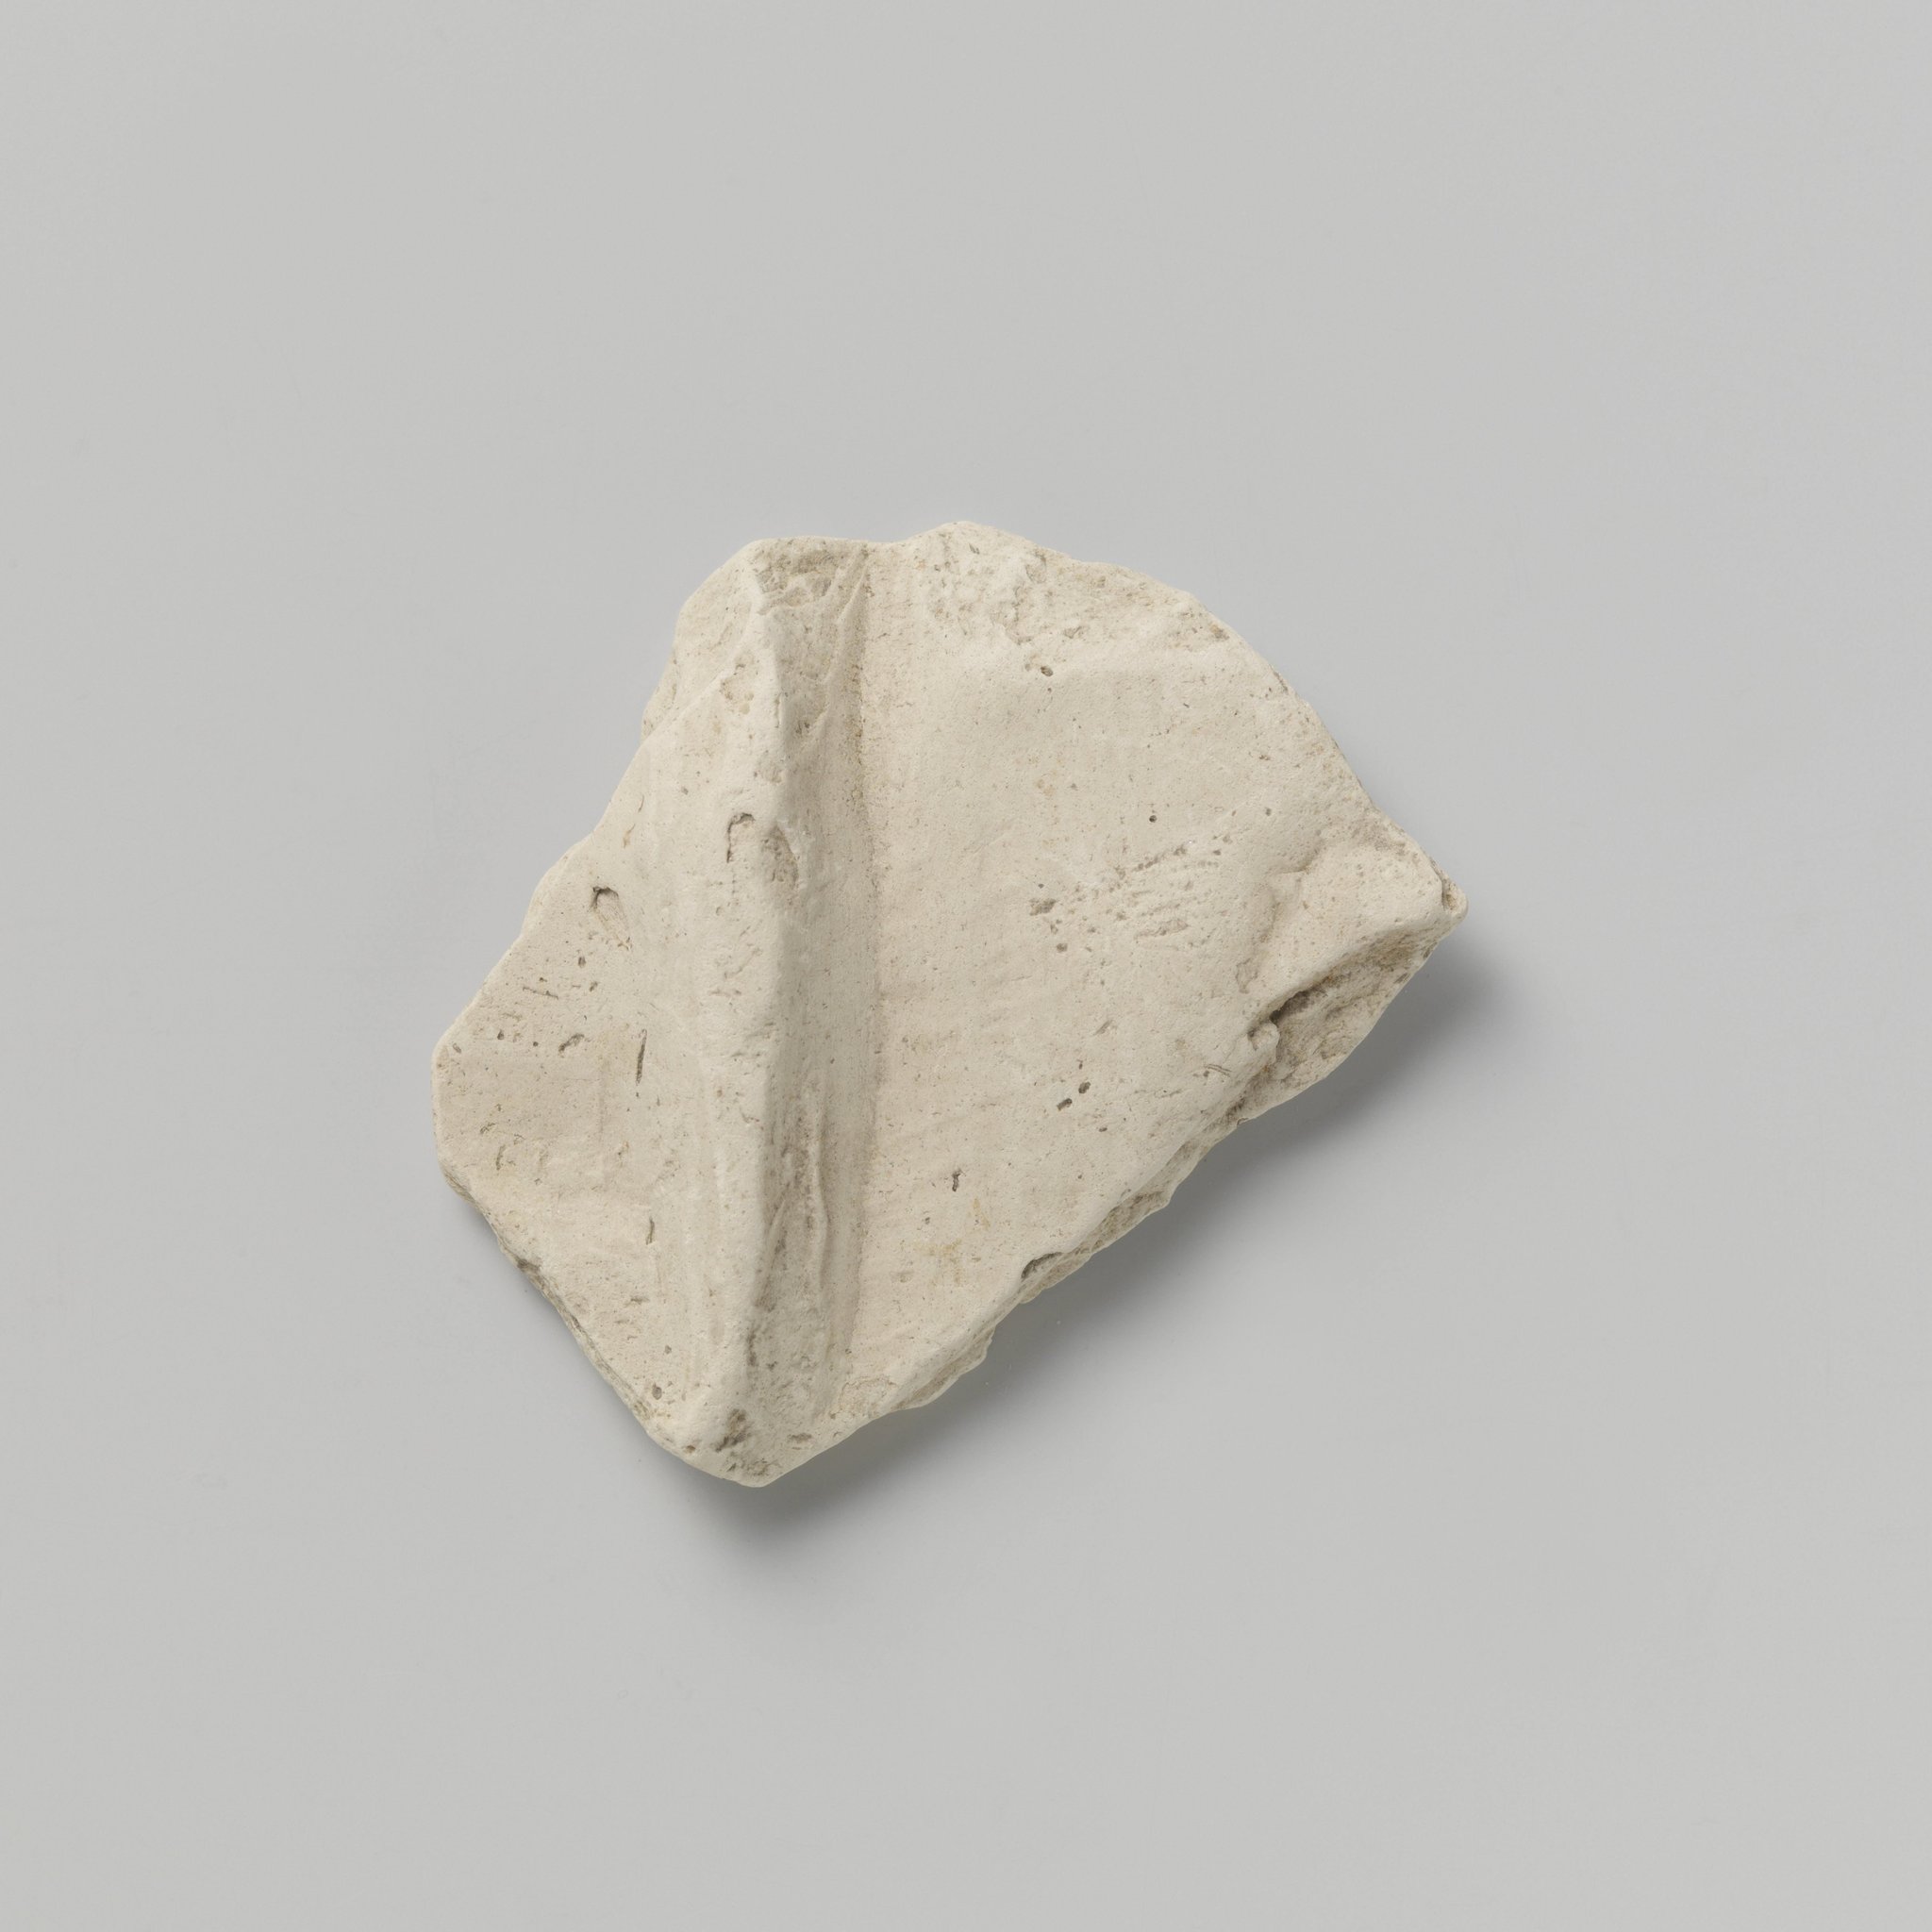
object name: sculpture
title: Figurine, Fragment of the Garment (?)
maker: Anonymous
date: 1425-1550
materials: clay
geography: northern netherlands